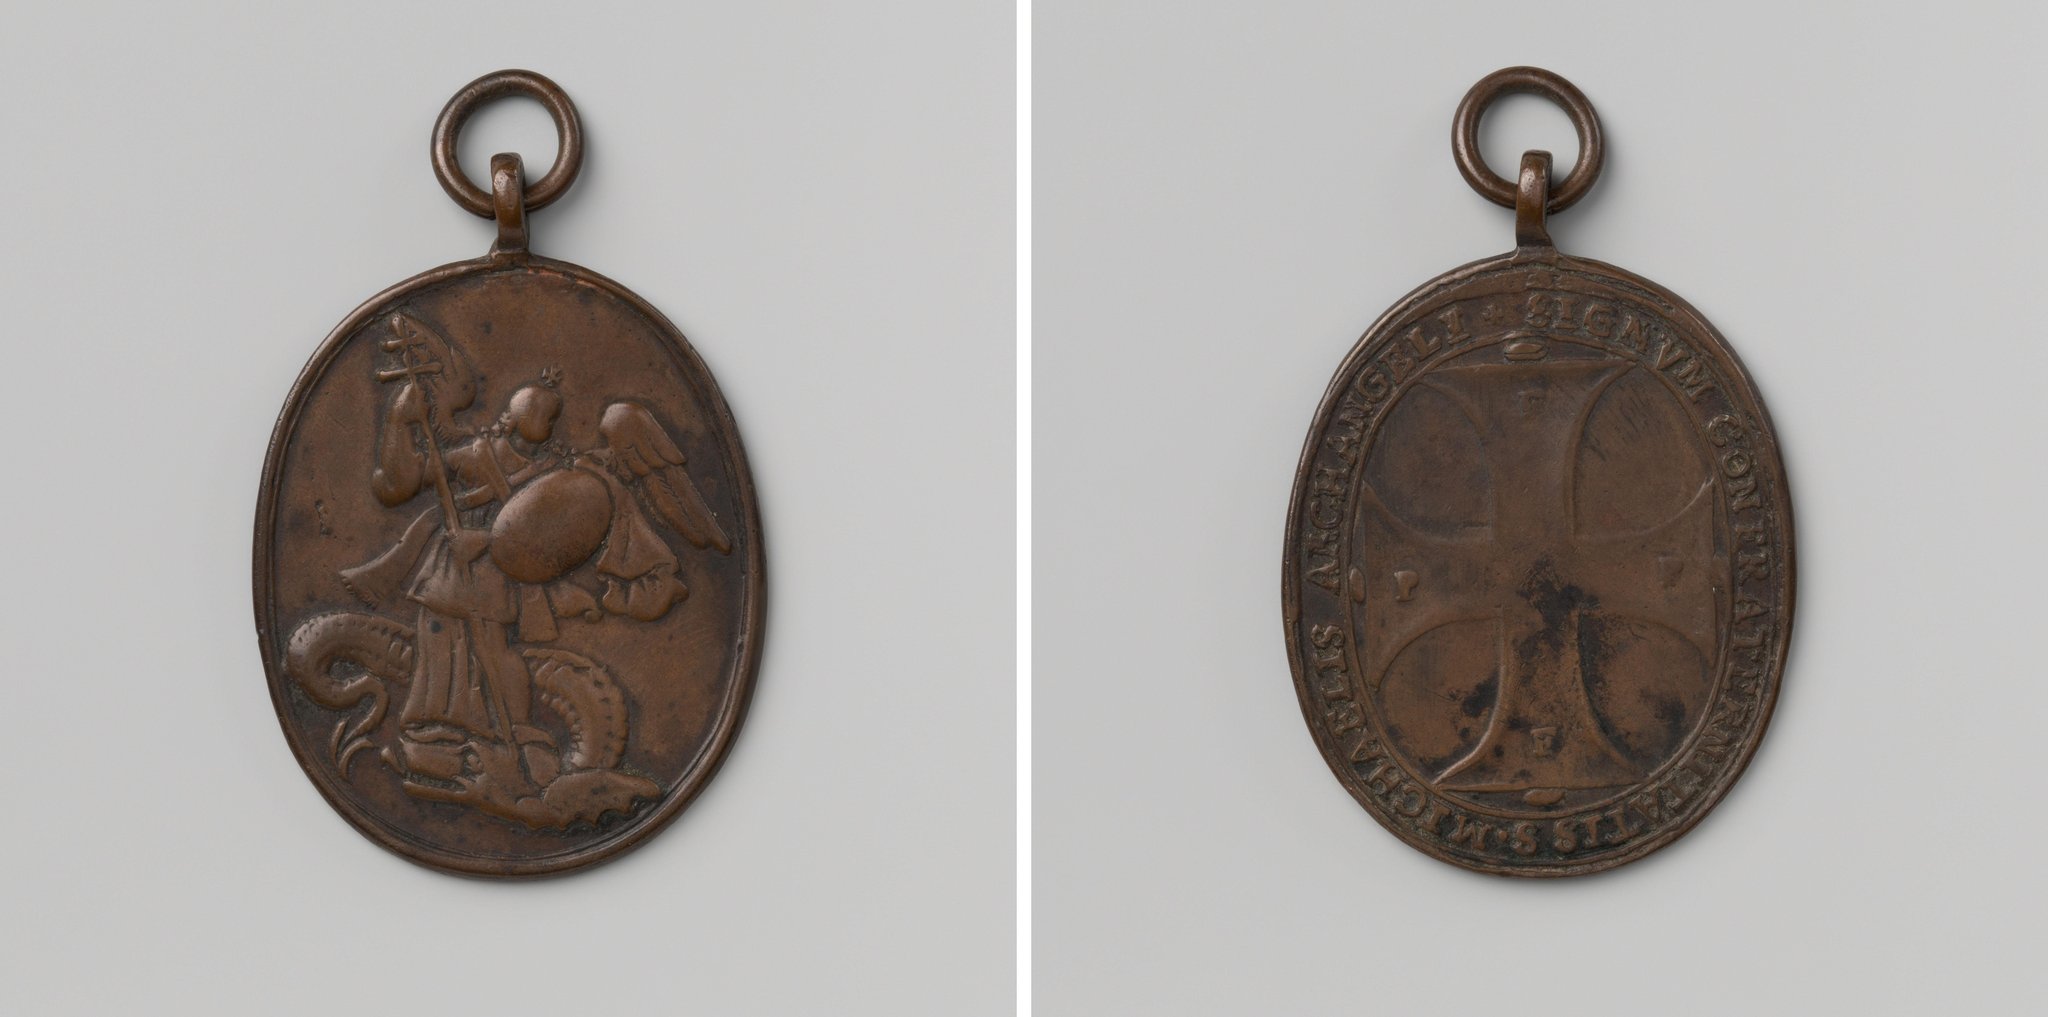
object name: marksman medal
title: Confrerie St. Michael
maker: Anonymous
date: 1600-1800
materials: bronze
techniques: casting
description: Bronzen ovale penning aan draagoog en draagring. Voorzijde: aartsengel Michael met kruis op hoofd, schild en gekruiste lans doorsteekt ter aarde liggende draak. Keerzijde: kruis met op horizontale armen letter P, op verticale armen letter F binnen omschrift